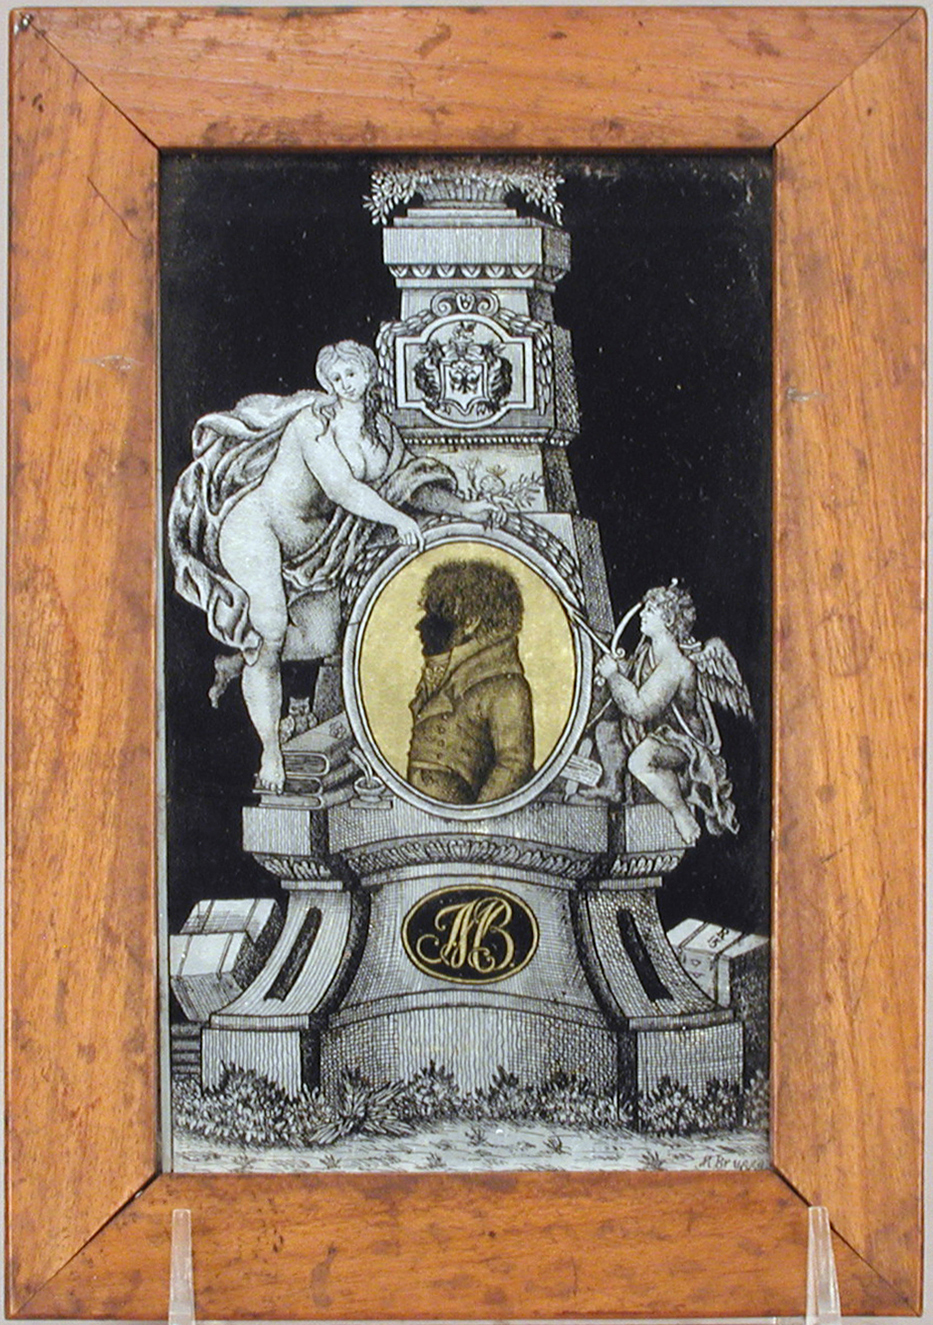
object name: panel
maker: m. bruggäy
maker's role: maker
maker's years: 1775-1875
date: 1801-1833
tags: men,profiles,female nudes,cupid,coat of arms